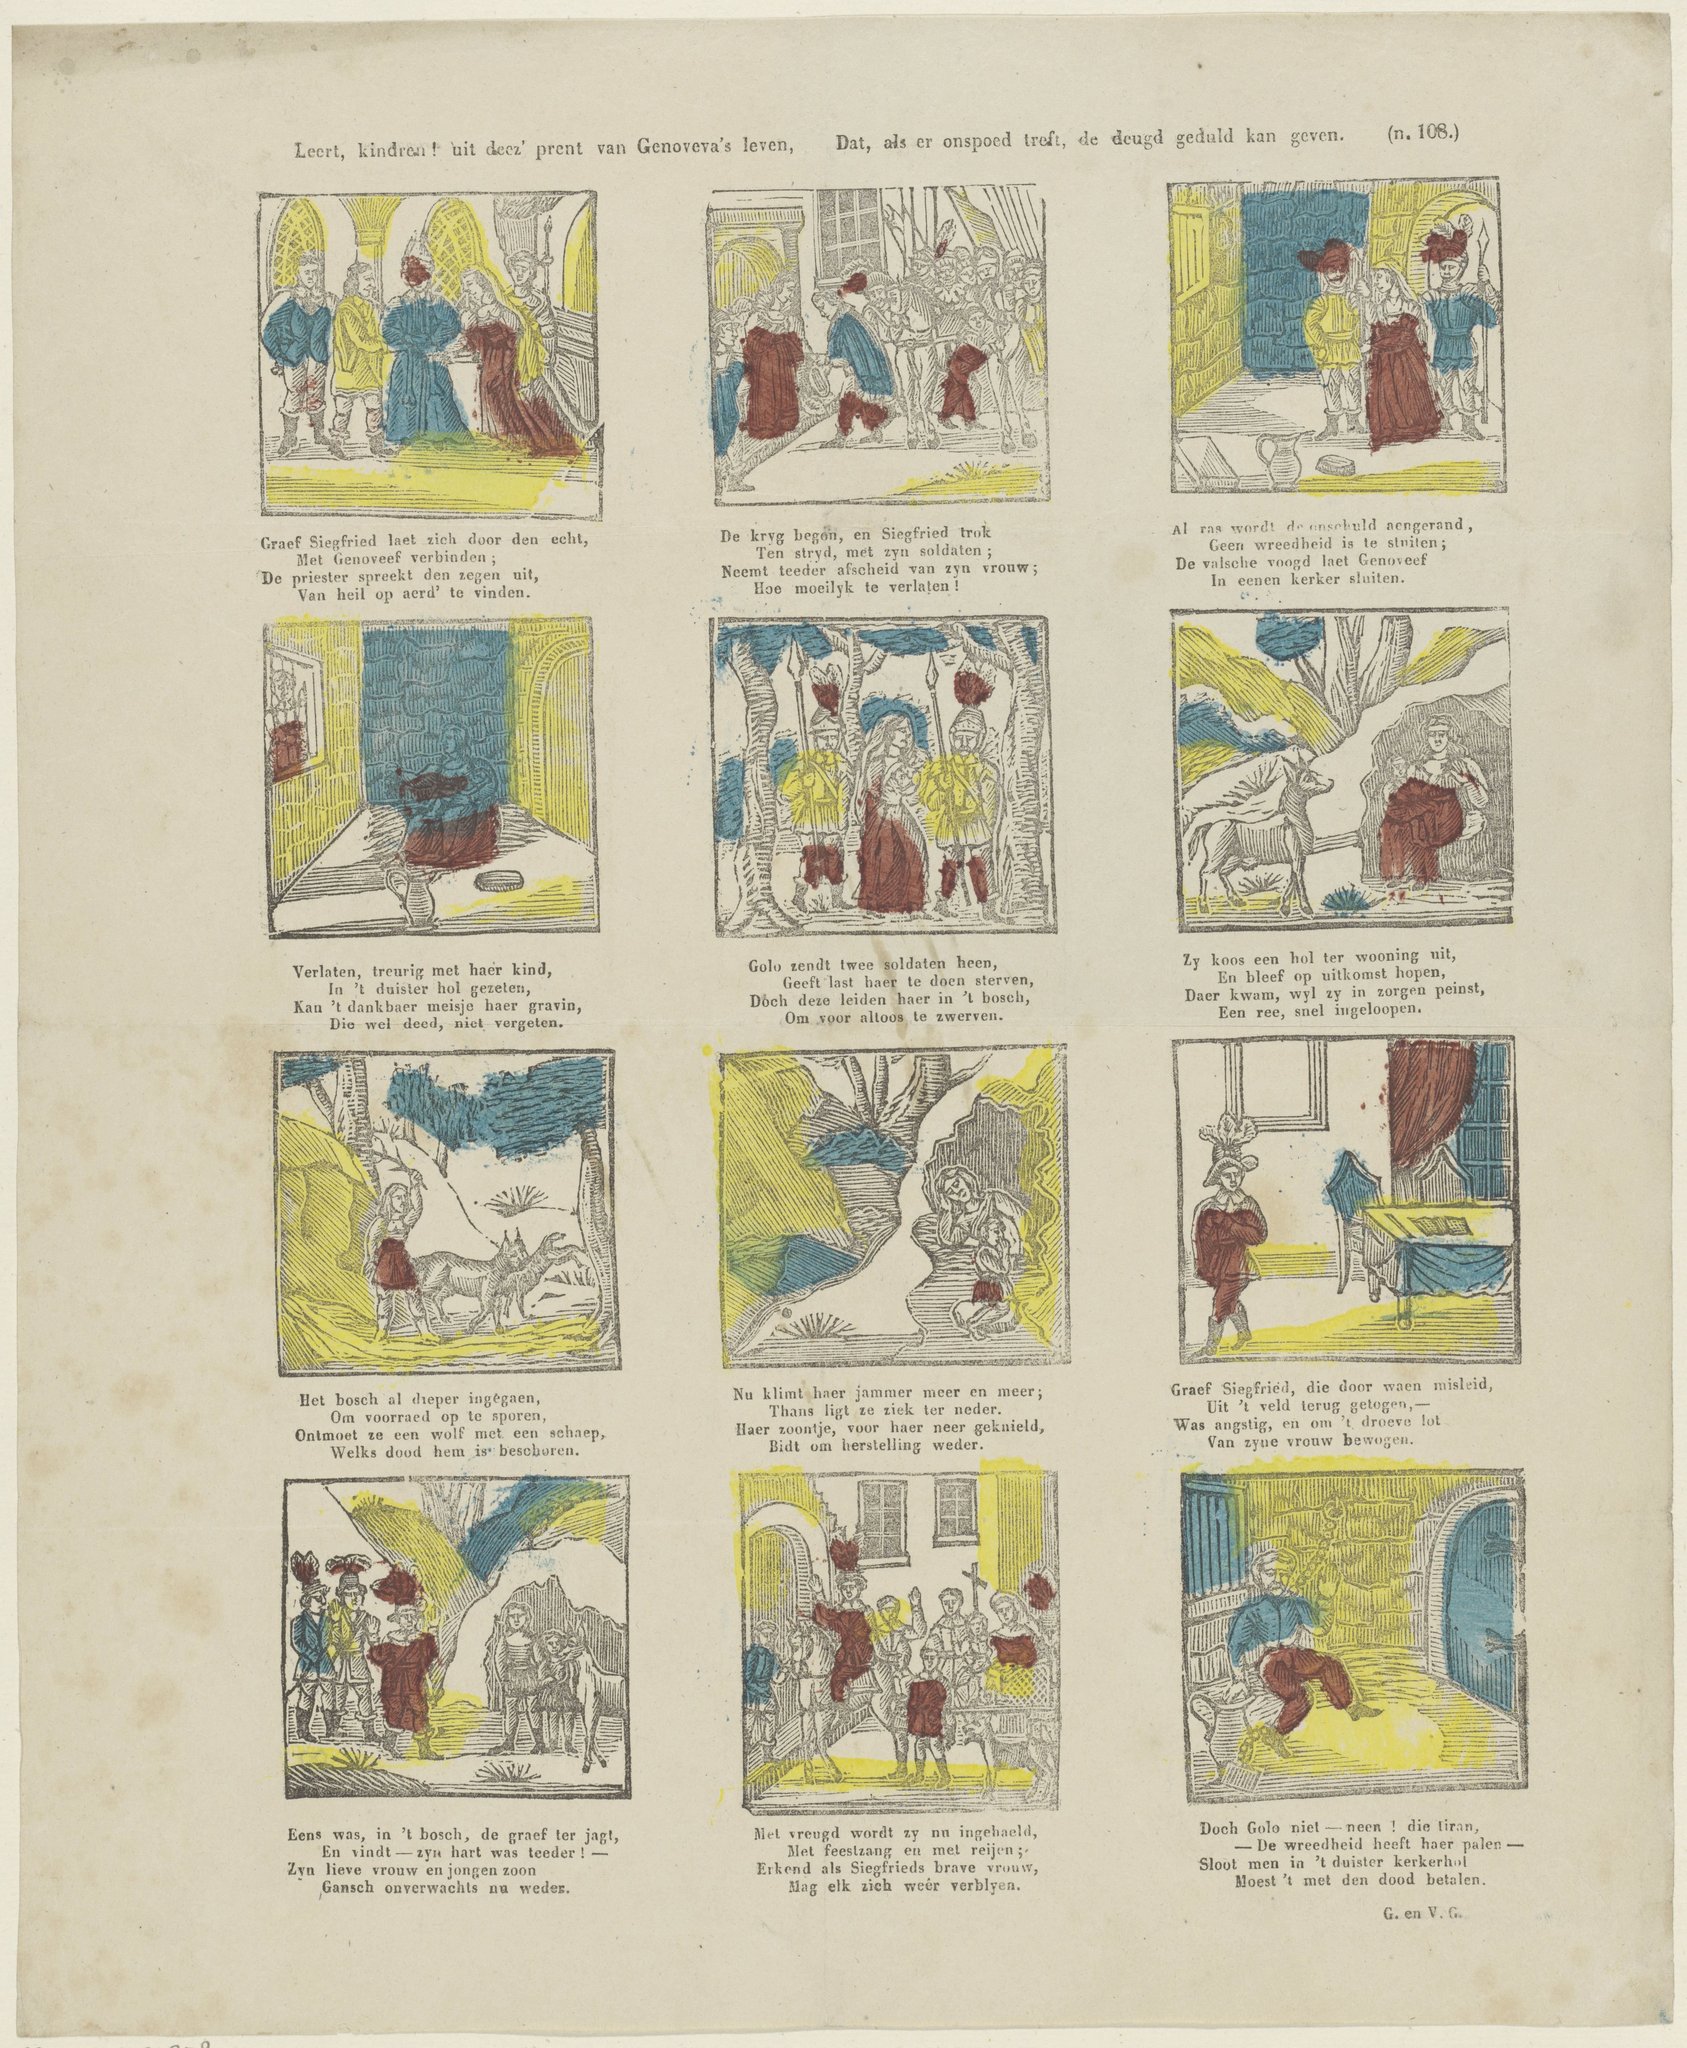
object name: popular print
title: Leert, kindren! uit deez' prent van Genoveva's leven, / Dat, als er onspoed treft, de deugd geduld kan geven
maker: Anonymous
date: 1833-1856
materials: paper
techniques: colour, letterpress printing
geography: turnhout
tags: genoveva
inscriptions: collector's mark: Lugt 2760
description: Blad met 12 voorstellingen over het leven van Genoveva van Brabant. Onder elke afbeelding een vierregelig vers. Genummerd rechtsboven: (n. 108.).